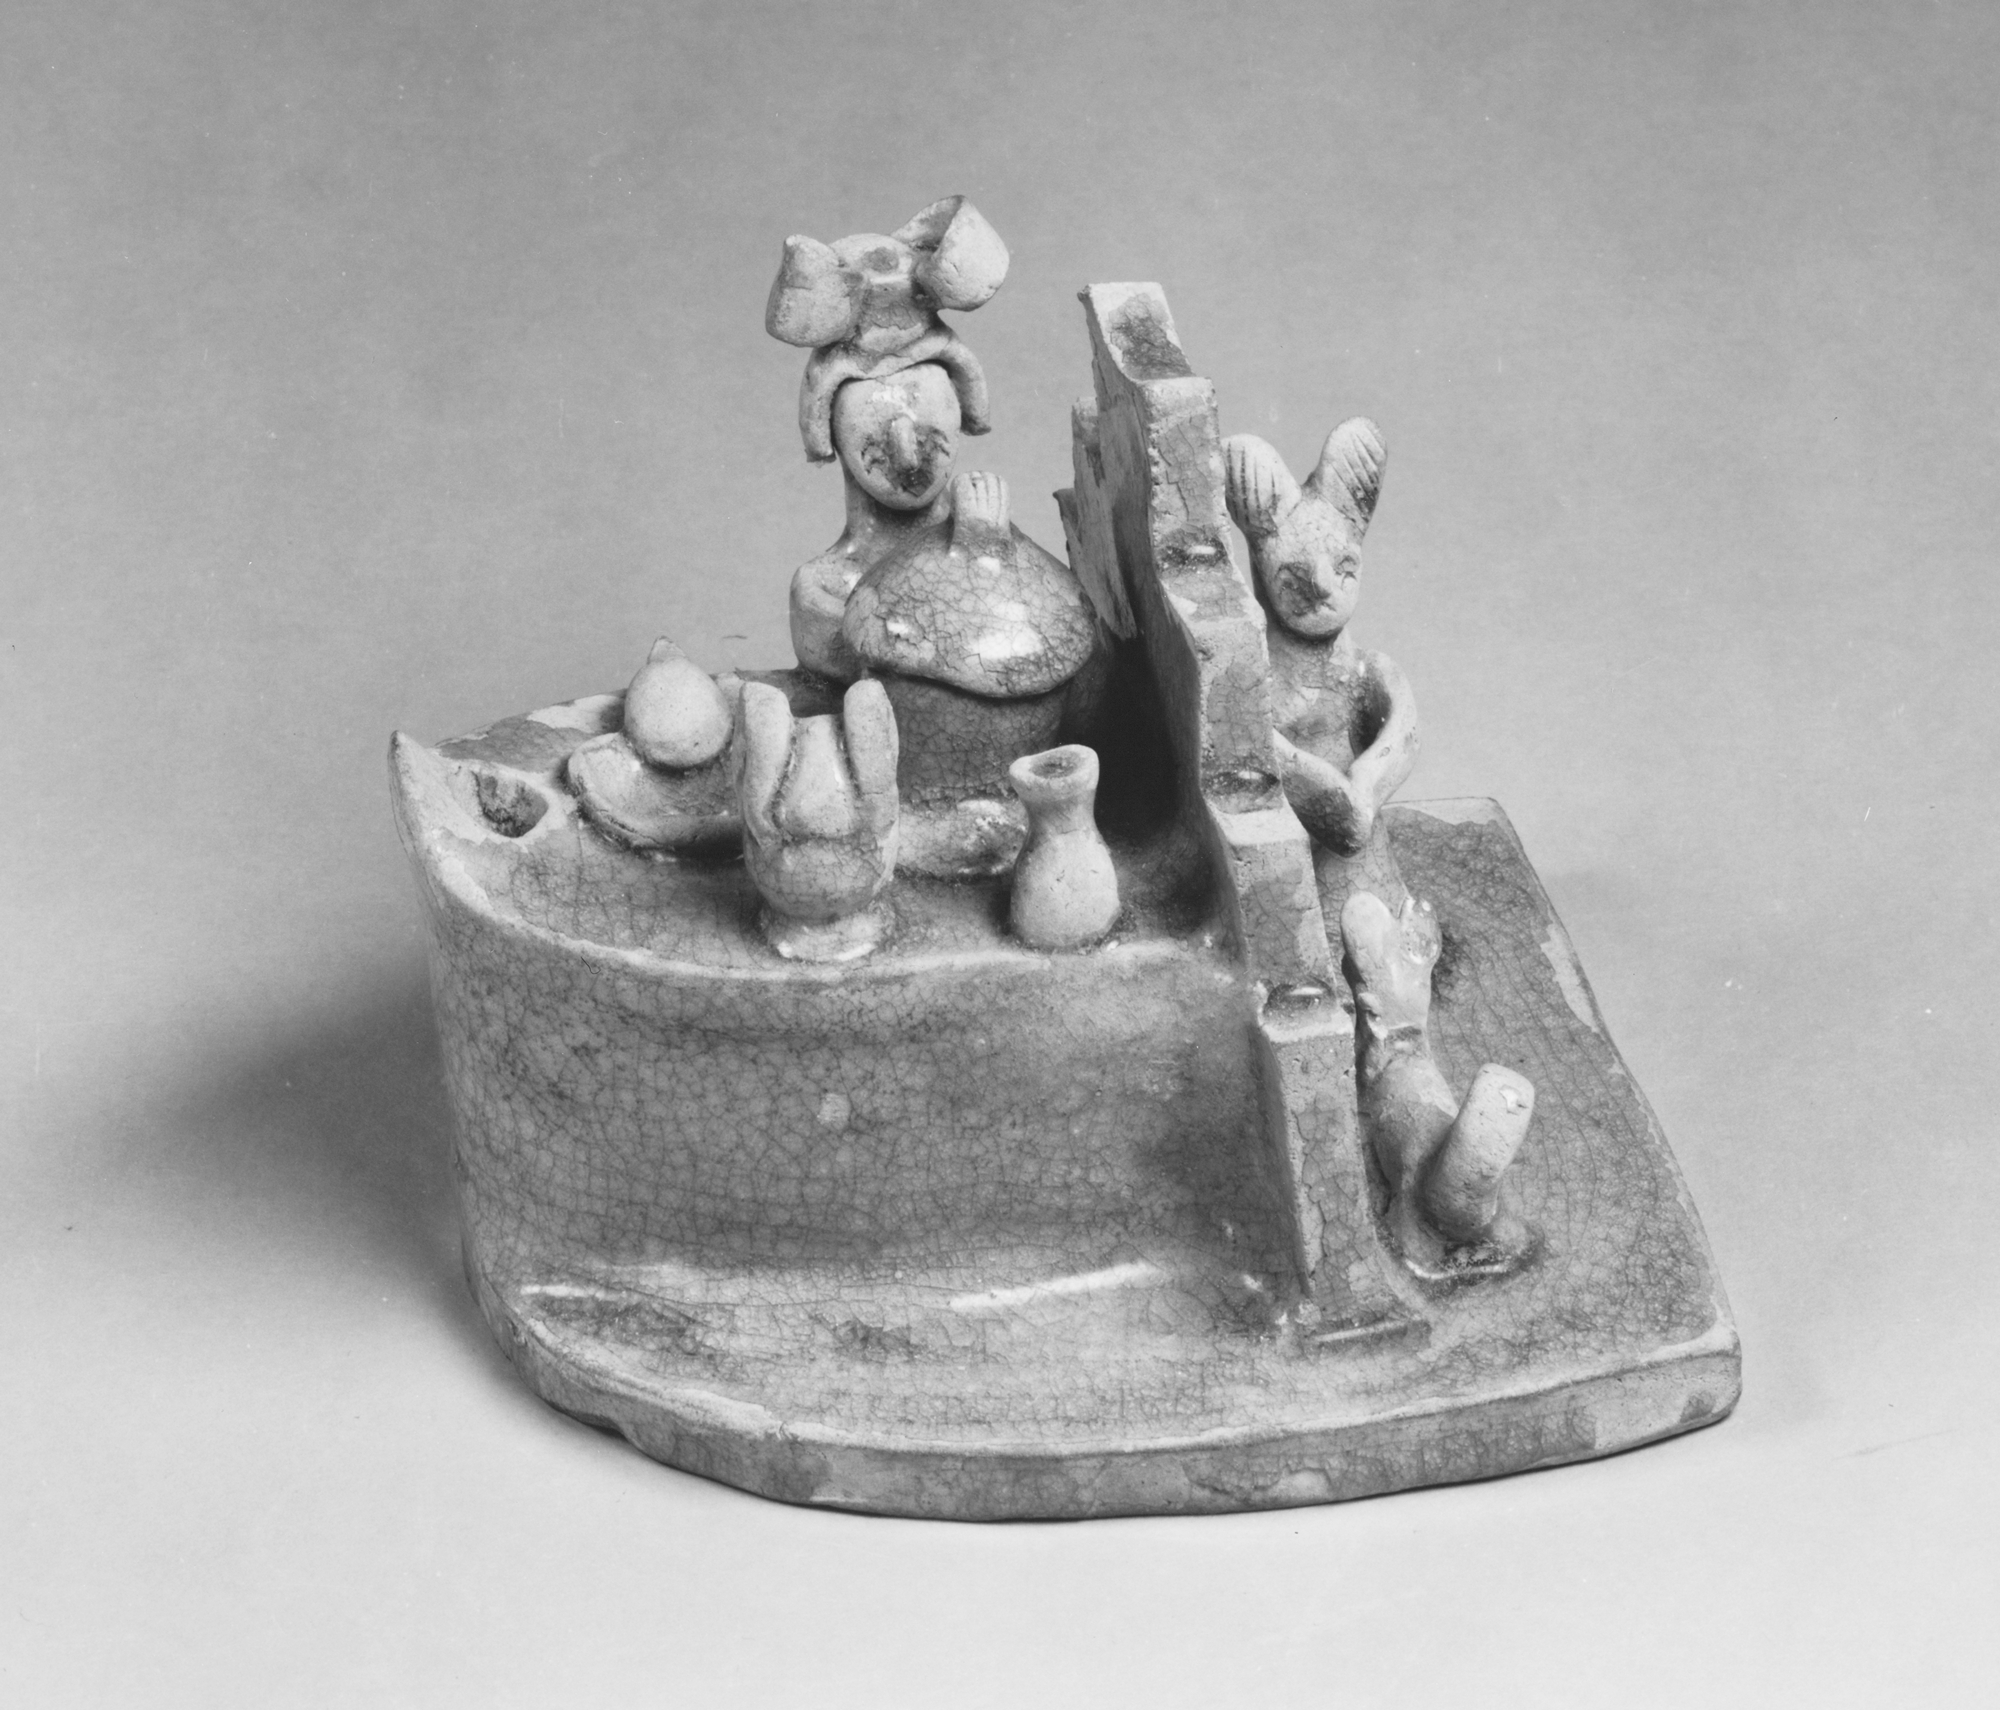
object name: stove with figure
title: Stove with figures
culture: chinese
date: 467-533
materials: glaze, stoneware